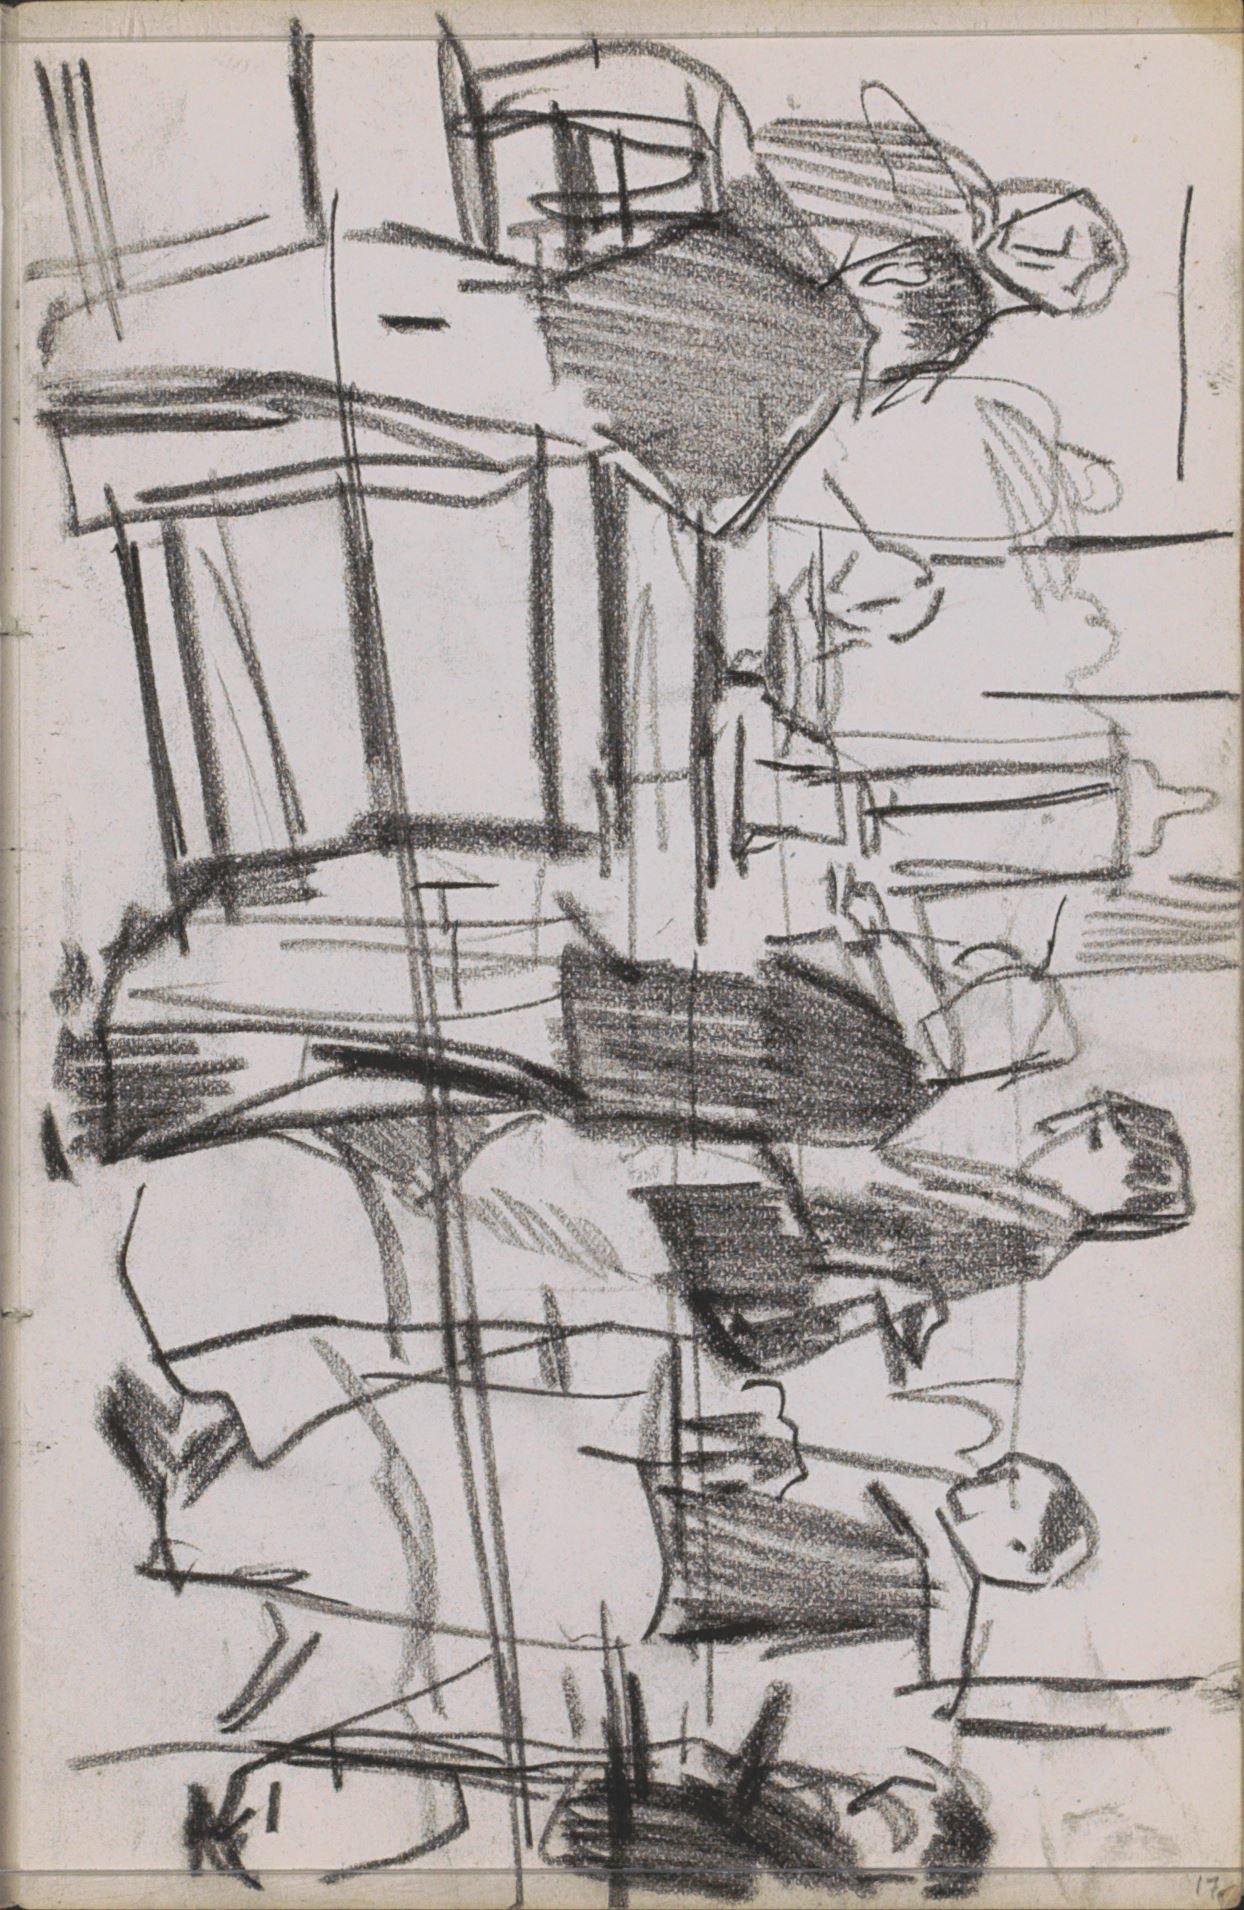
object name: sketchbook leaf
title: Figuren, mogelijk aan een bar of toonbank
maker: isaac israels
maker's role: draughtsman, painter, print maker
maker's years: 1865-1934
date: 1875-1934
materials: chalk, paper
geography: amsterdam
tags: counter ~ shop, adult woman (+ standing), adult man (+ standing)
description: Pagina 17 uit schetsboek XXIX met 44 pagina's.